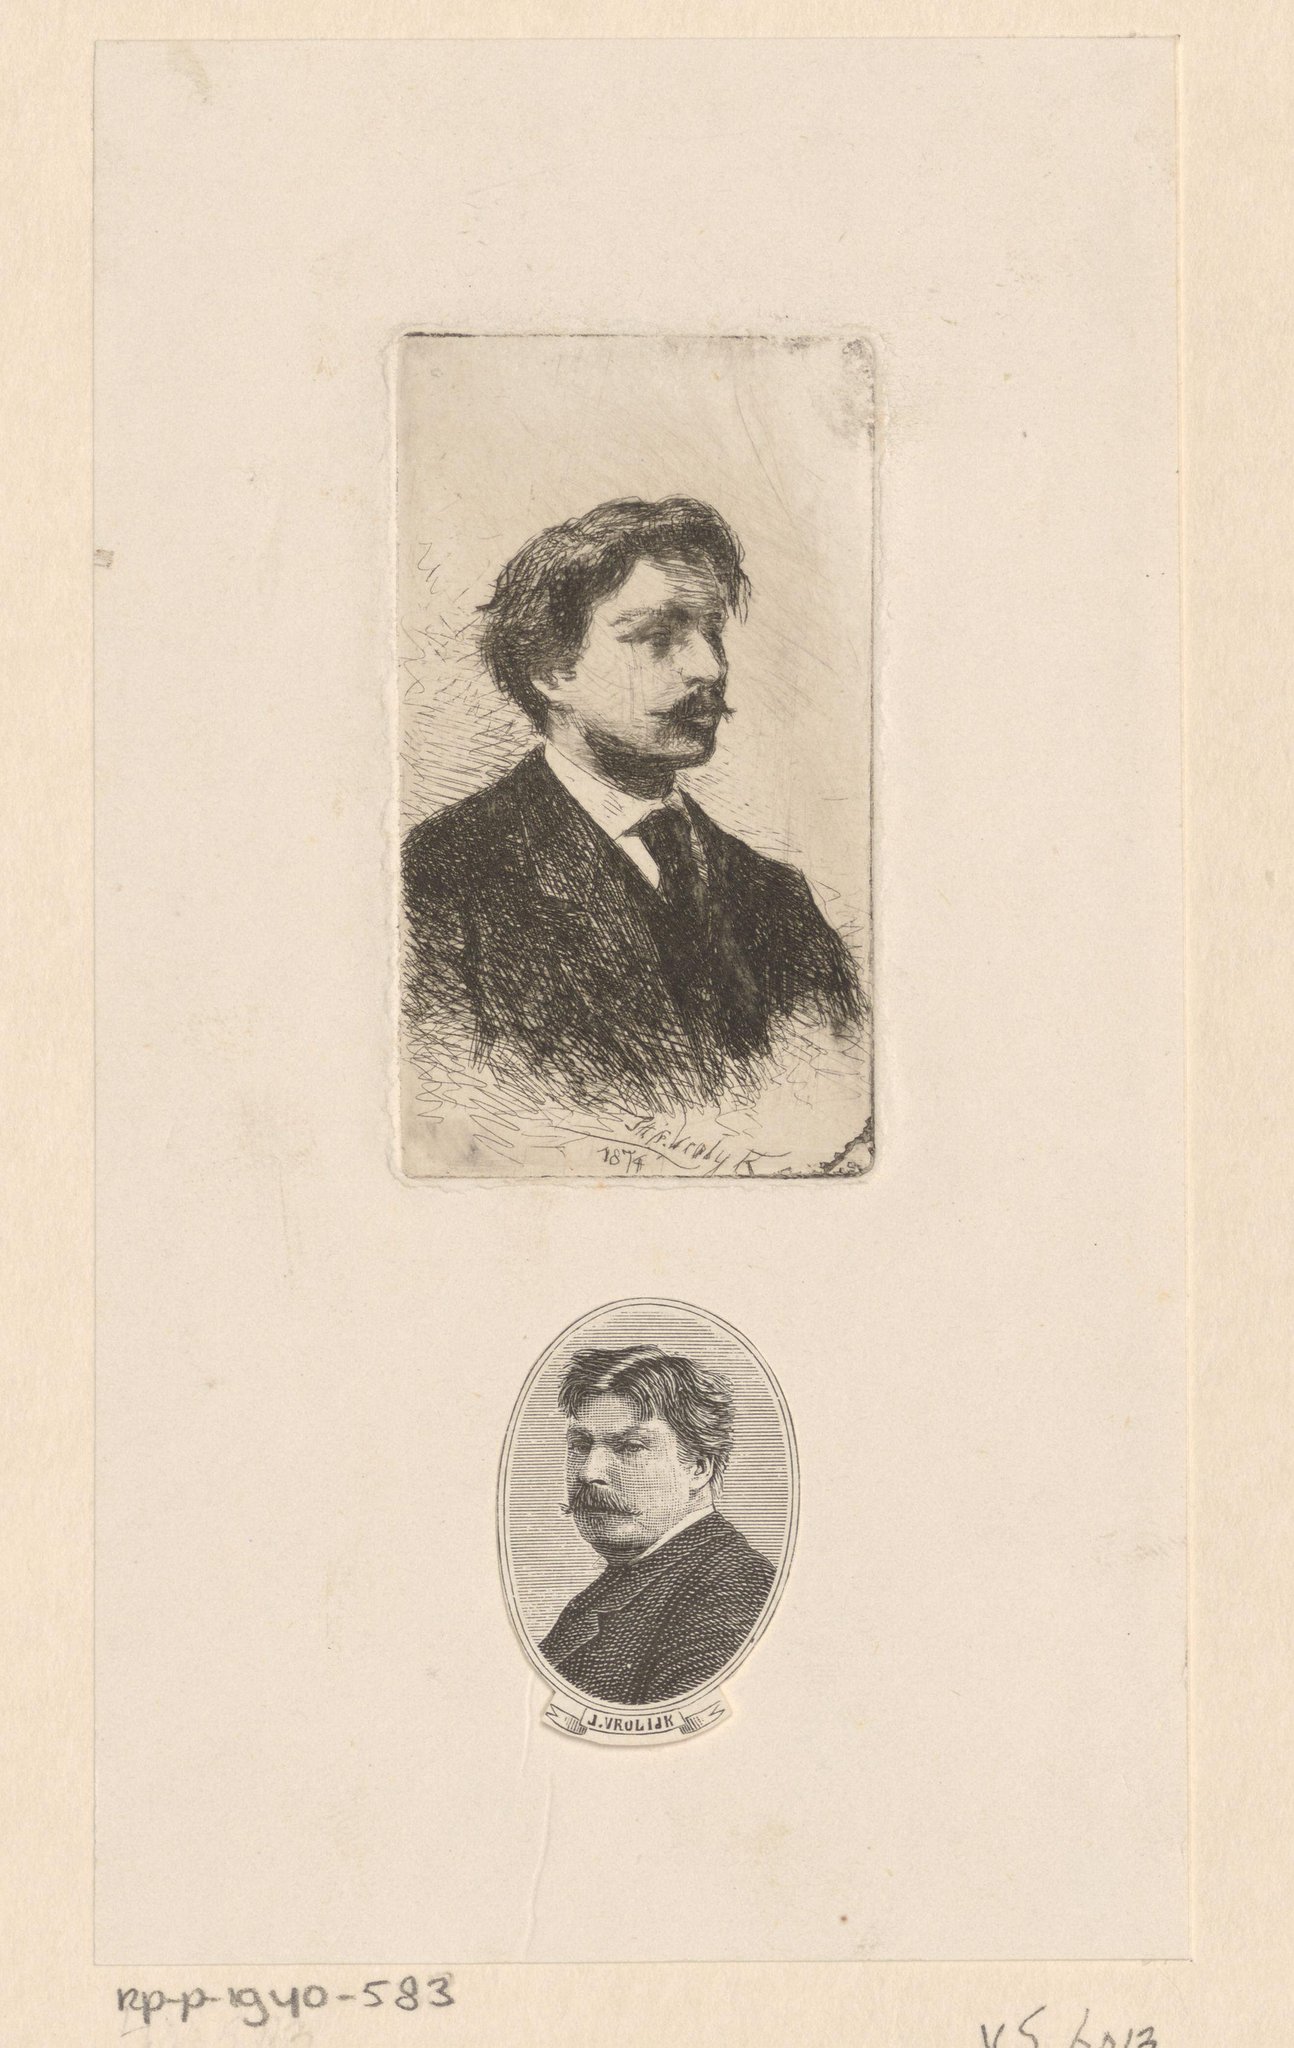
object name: print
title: Zelfportret, en een portret van Jan Vrolijk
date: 1874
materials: paper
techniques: etching, engraving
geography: the hague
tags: the hague, print maker, draughtsman, jan vrolijk, historical persons, portrait, self-portrait of painter, portrait, self-portrait of graphic artist, portrait, self-portrait of draughtsman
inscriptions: collector's mark: Lugt 2228, collector's mark: Lugt 2760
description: Het portret van Jan Vrolijk is onder het zelfportret geplakt.